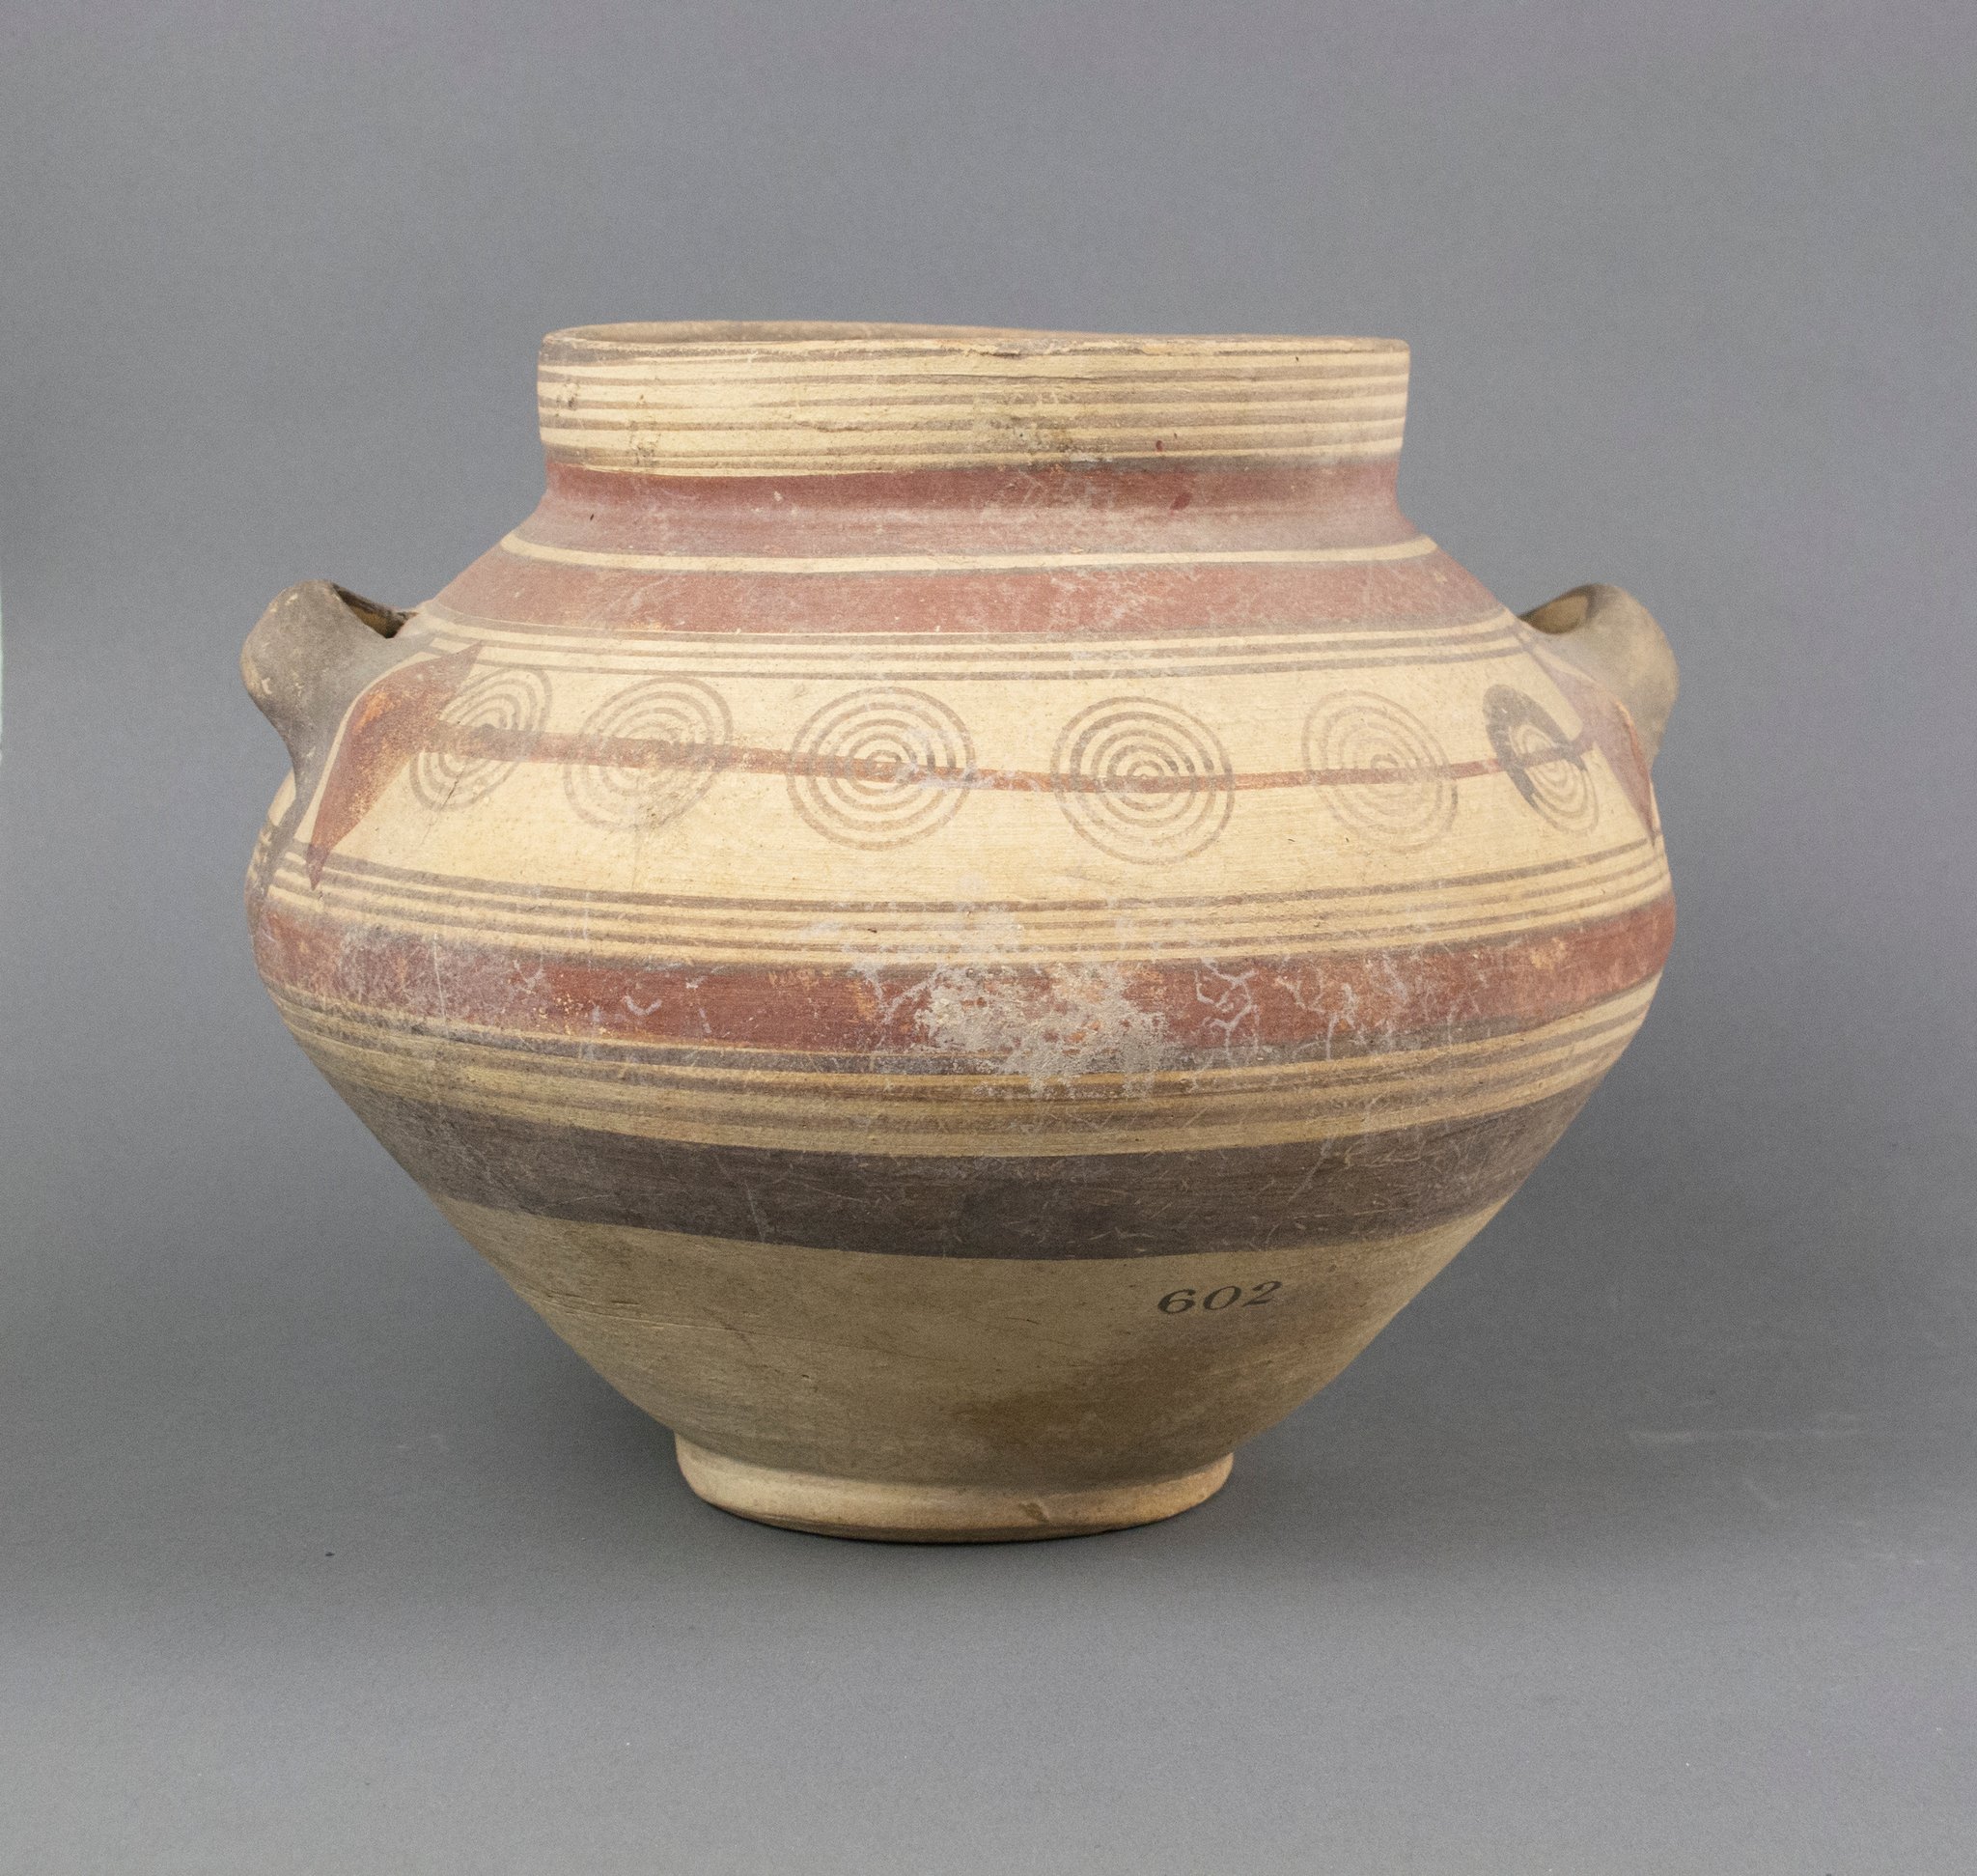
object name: dinos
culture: cypriot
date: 600-480 BCE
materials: terracotta